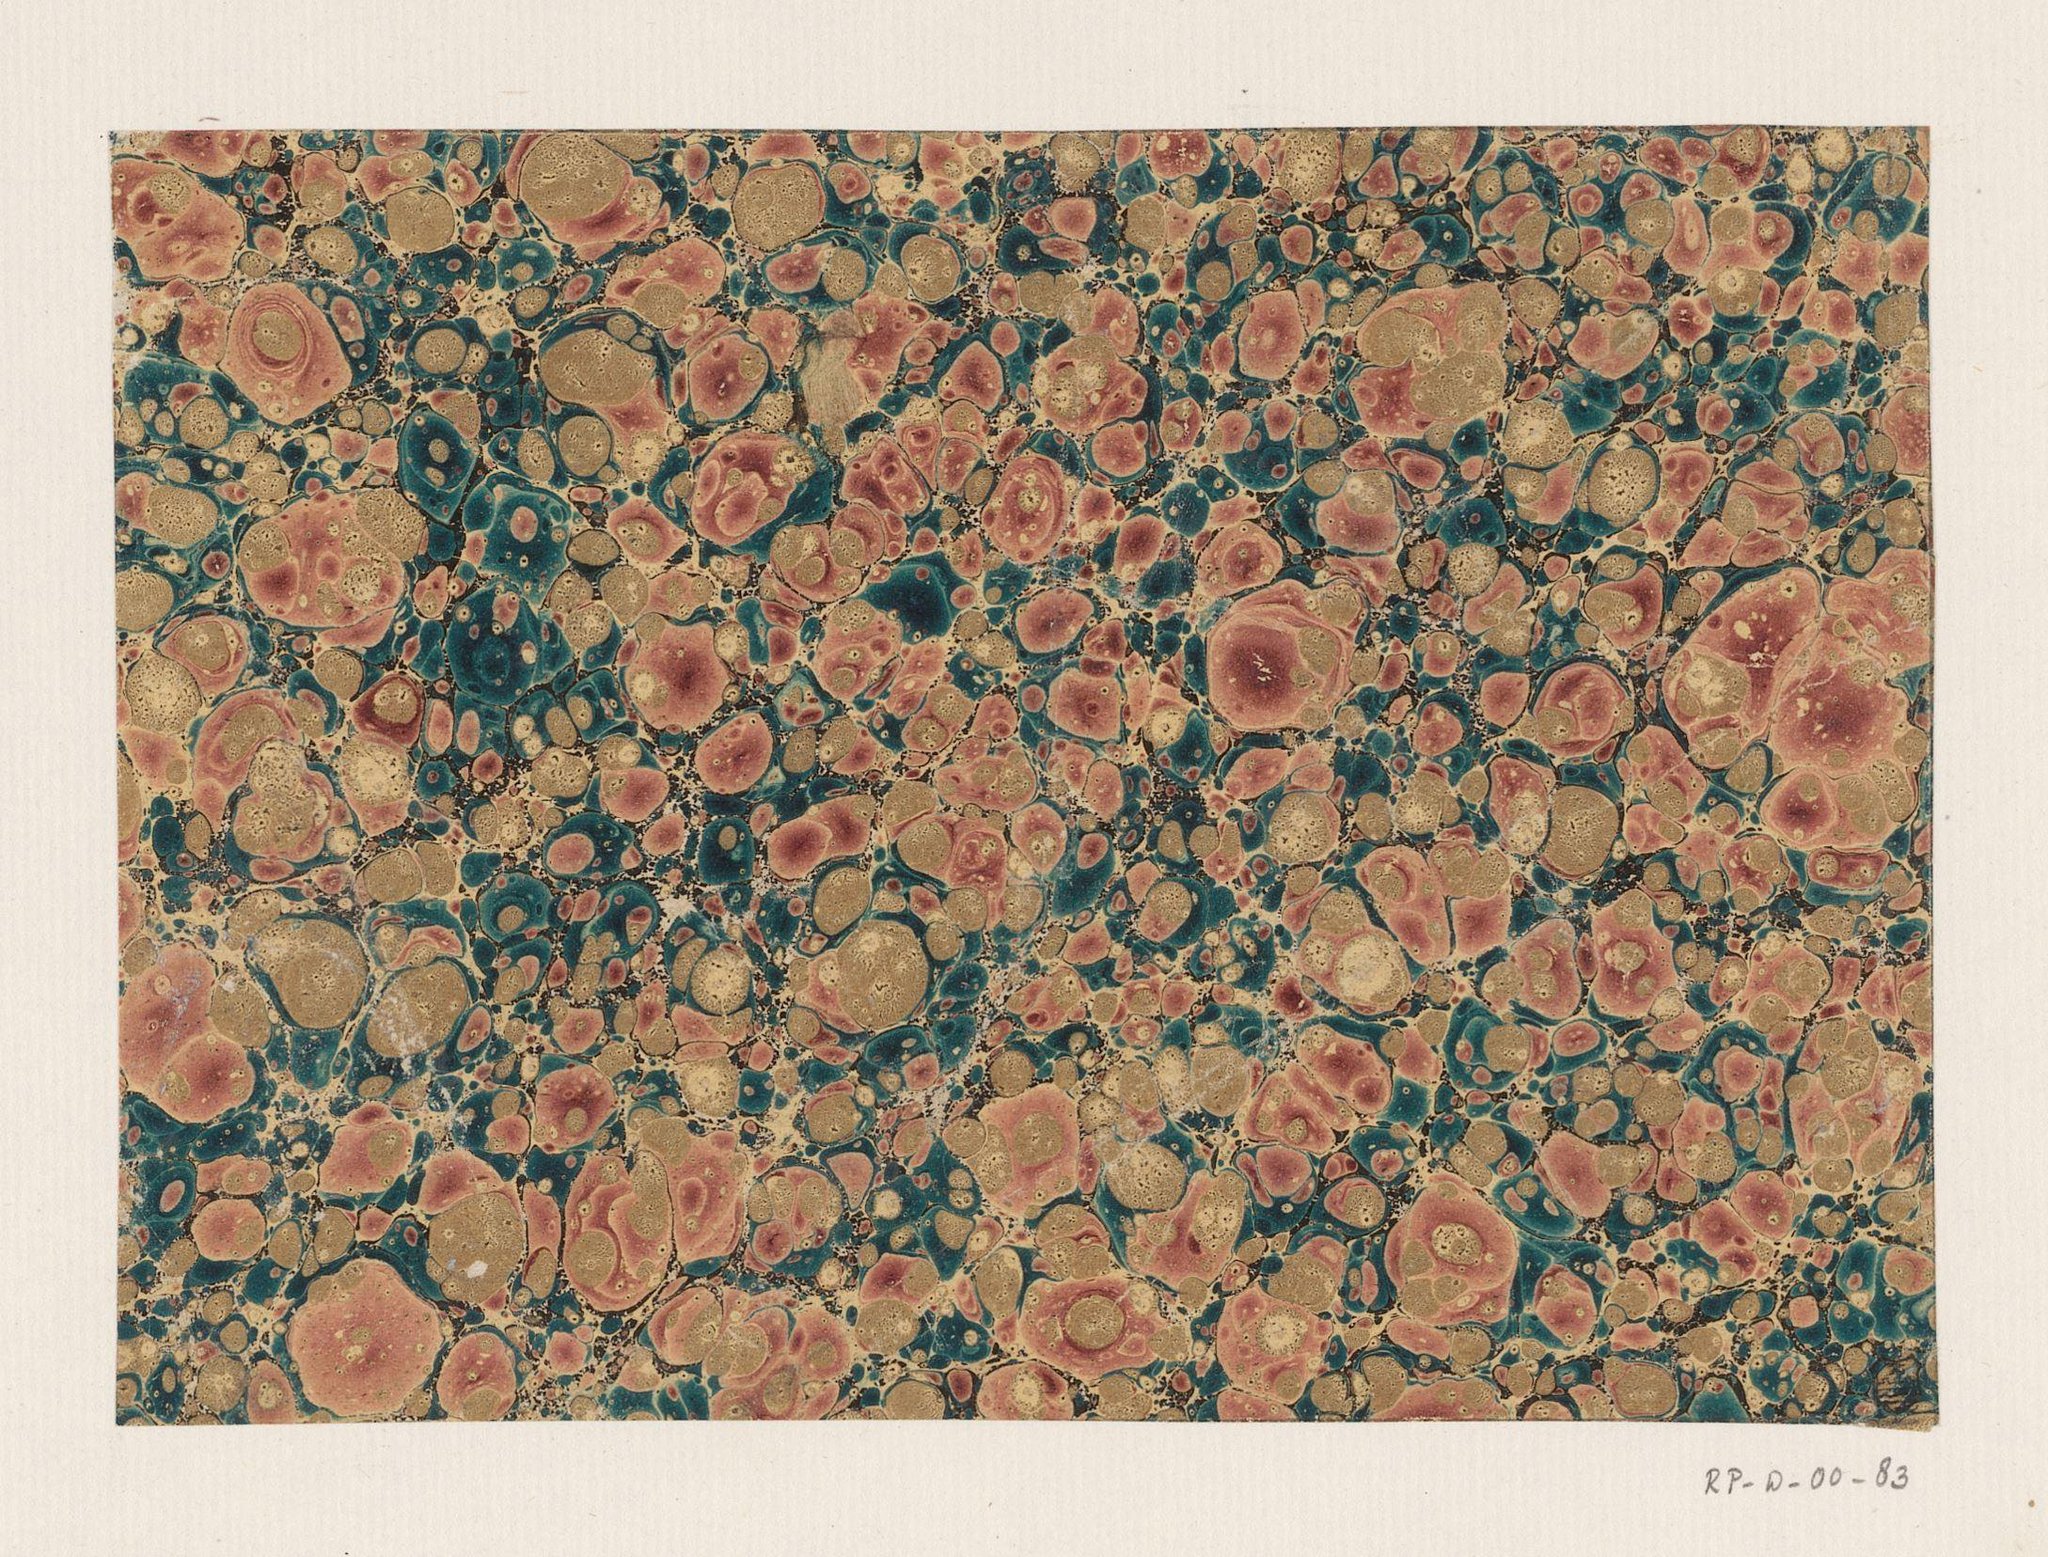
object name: marbled paper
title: Graniet-kiezelmarmer in zwart, groen, roze en bruin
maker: Anonymous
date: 1700-1850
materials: paint, paper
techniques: marbling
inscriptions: collector's mark: Lugt 2760